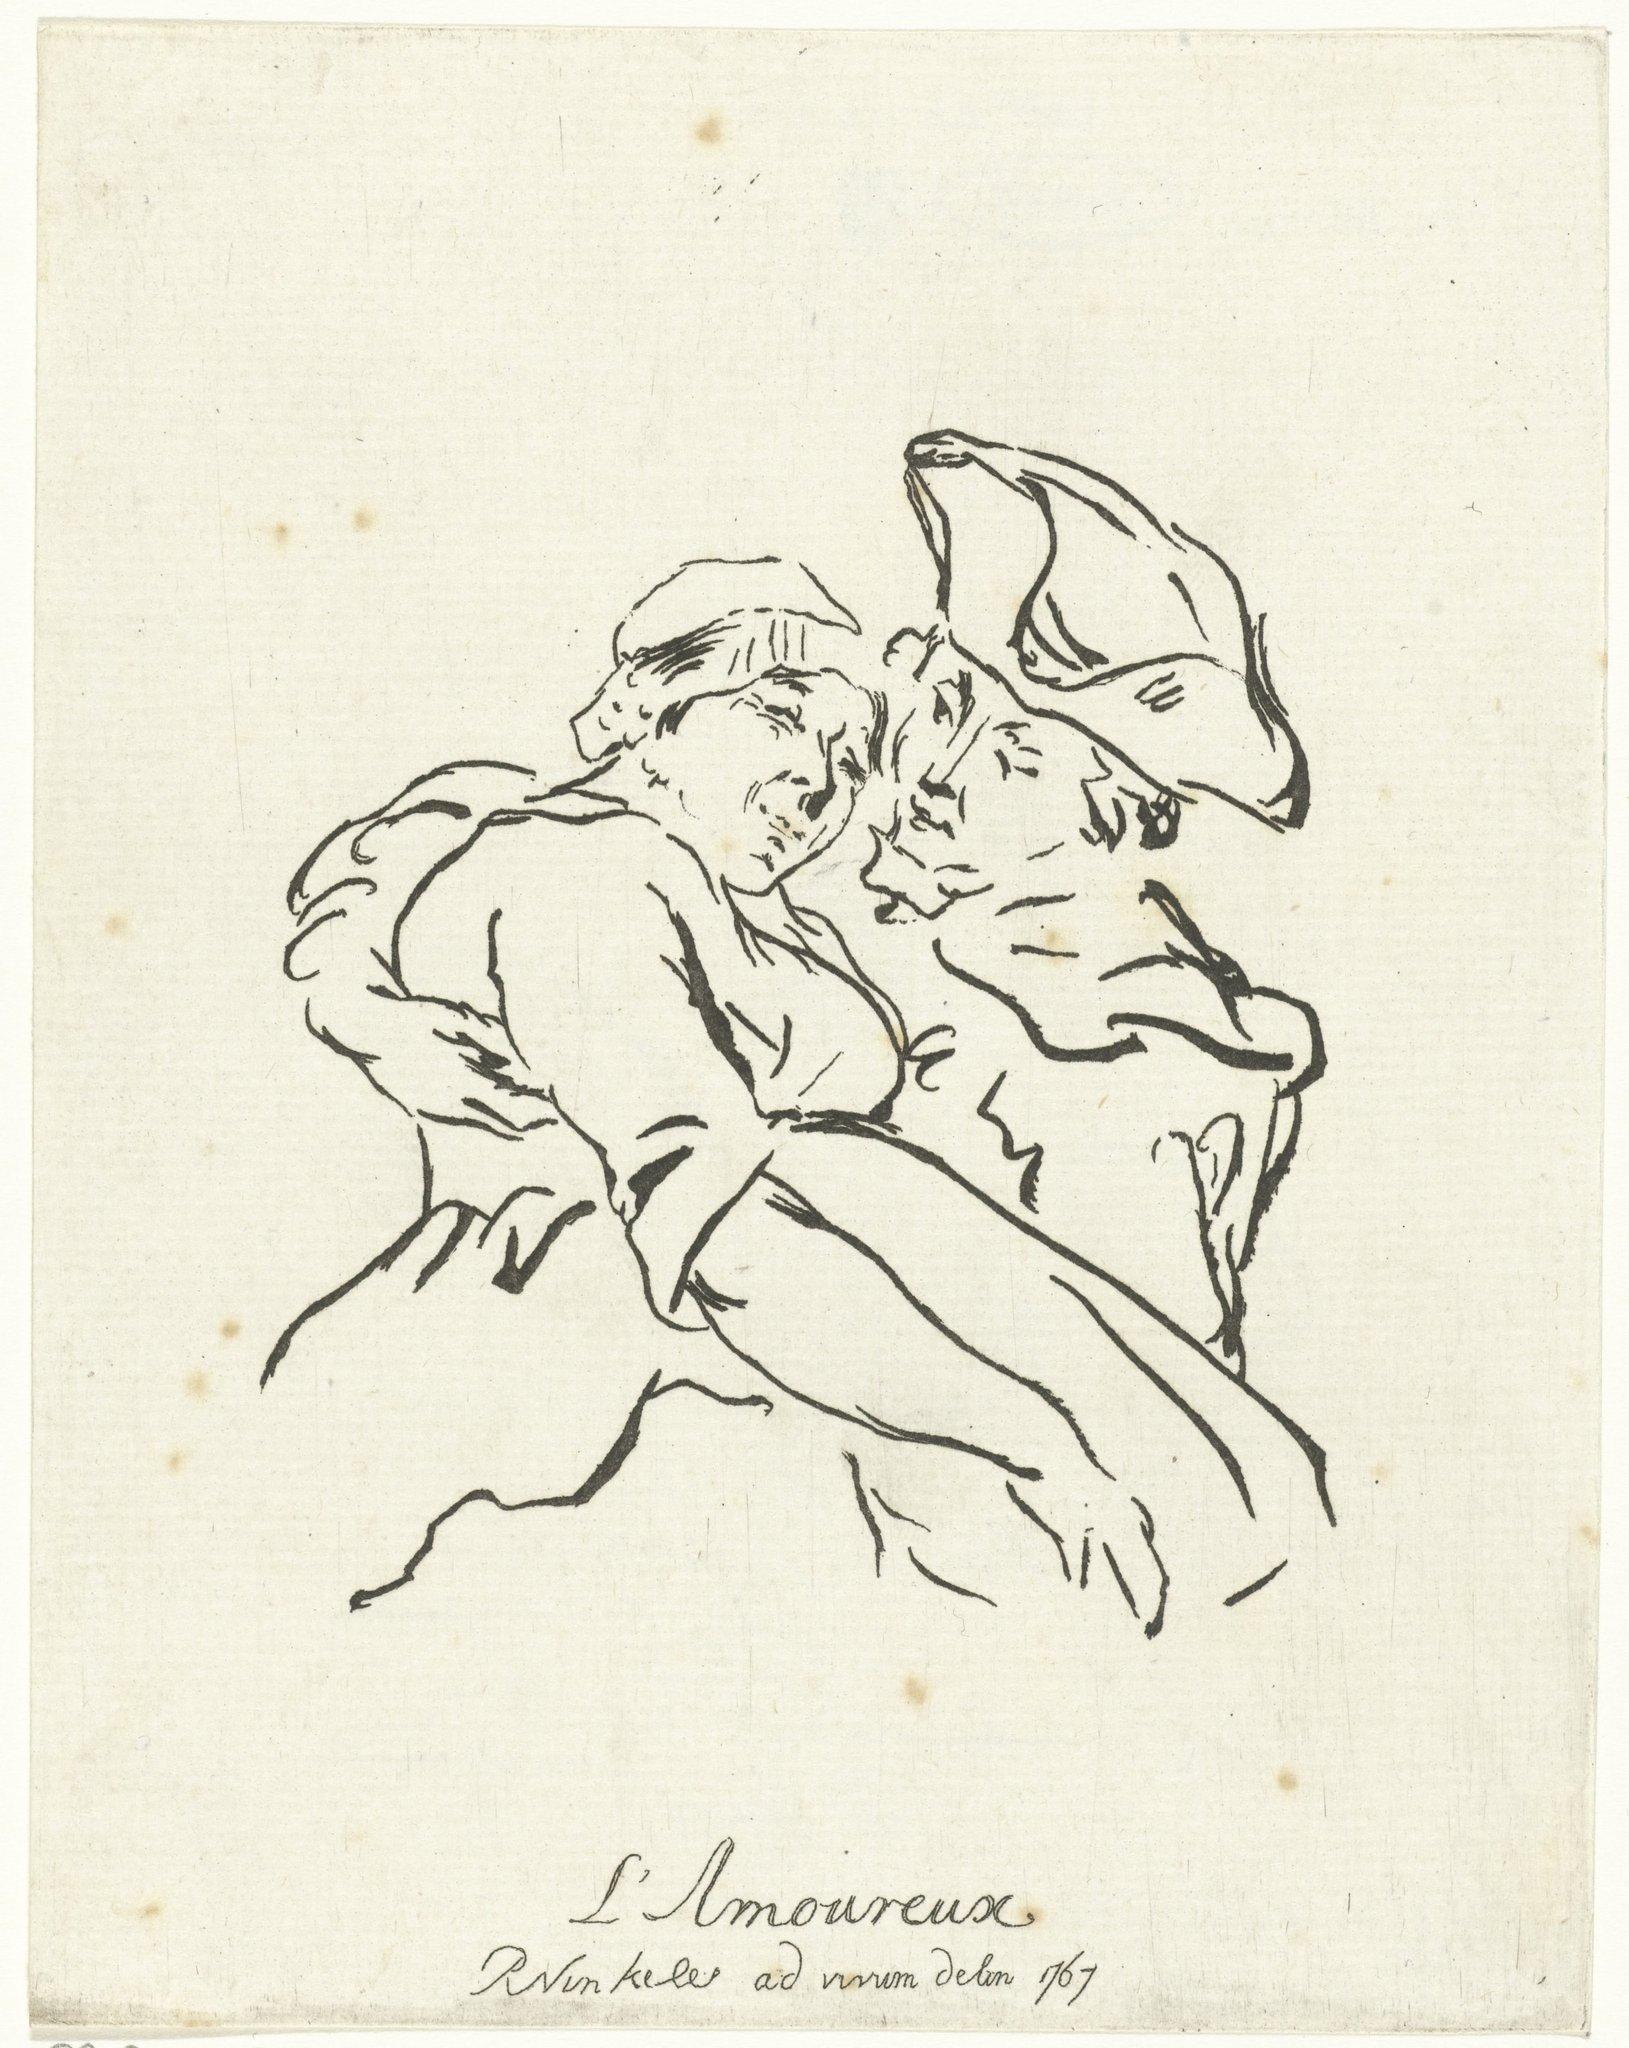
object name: print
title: L' Amoureux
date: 1767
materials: paper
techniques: etching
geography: amsterdam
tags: (lovers) embracing each other, 'symplegma'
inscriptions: collector's mark: Lugt 2228, inscription: ‘Geoffreerd aan mijnen waarde vriend de heer Hemsterhuis P v A 1 proef // R Vinkelis del Ploos v Amstel JC Fecit’, collector's mark: Lugt 2760